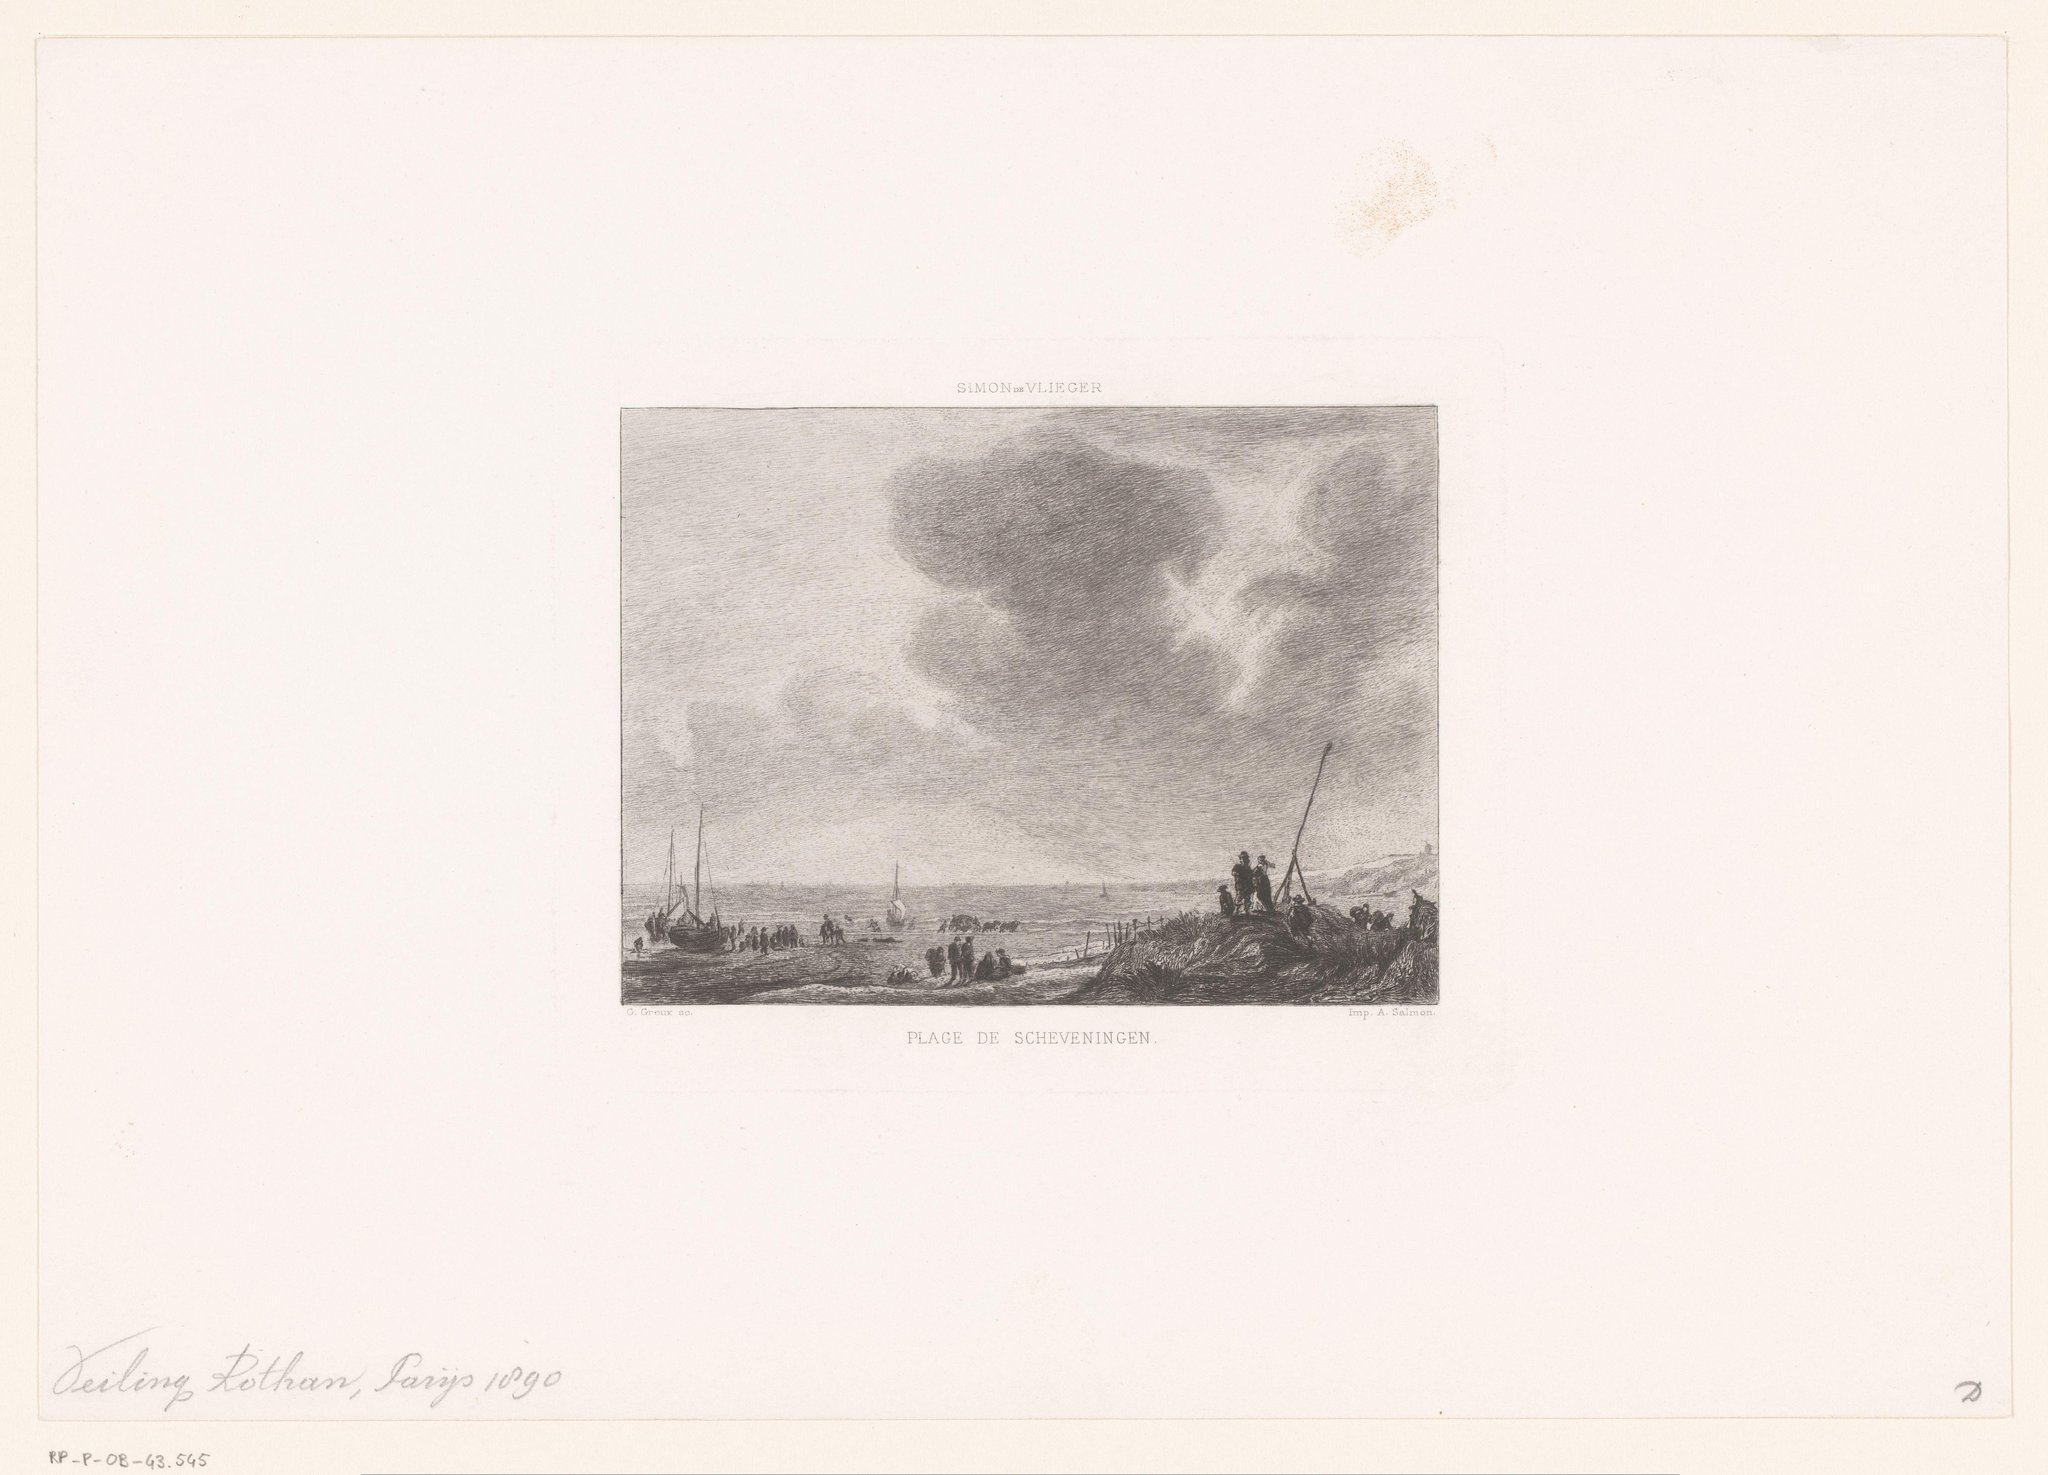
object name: print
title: Plage de Scheveningen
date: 1848-1919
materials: paper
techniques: etching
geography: paris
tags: beach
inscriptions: collector's mark: Lugt 2228